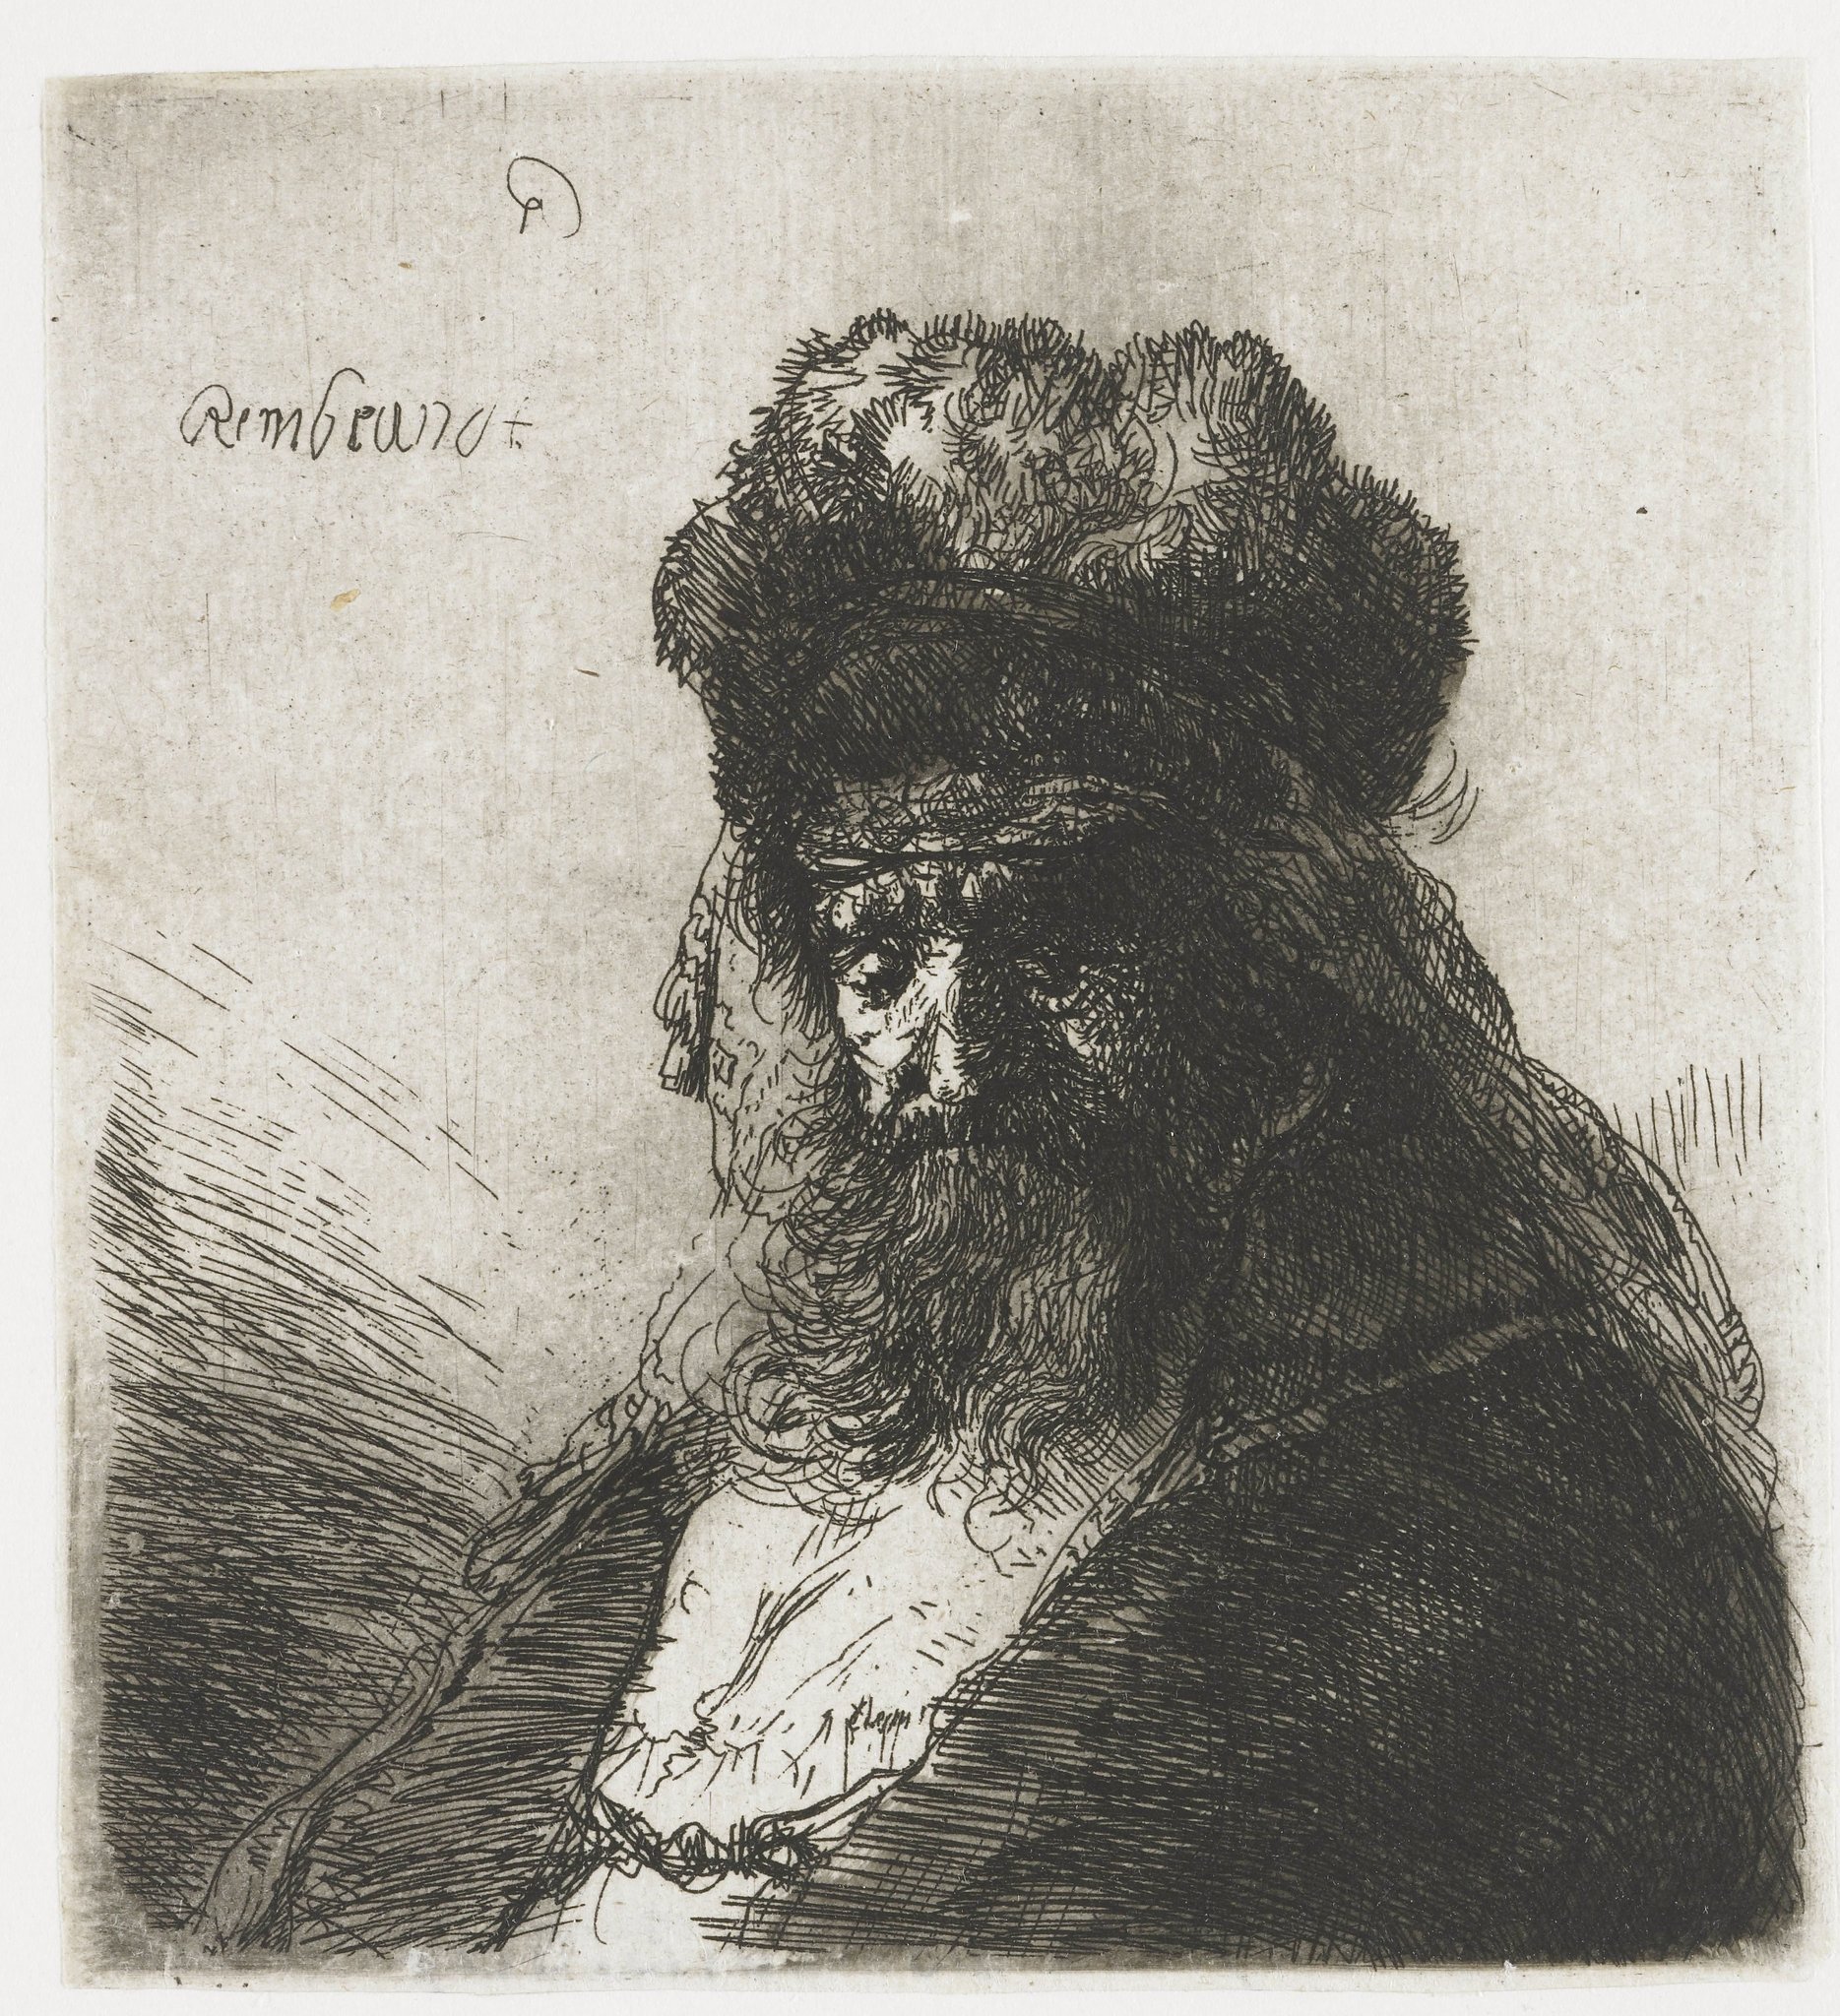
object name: print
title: Bearded old man in a high fur cap, with eyes closed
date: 1635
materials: paper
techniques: etching, intaglio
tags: head-gear (with name)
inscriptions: signature: ‘Rembrandt’, mark: Lugt 2165